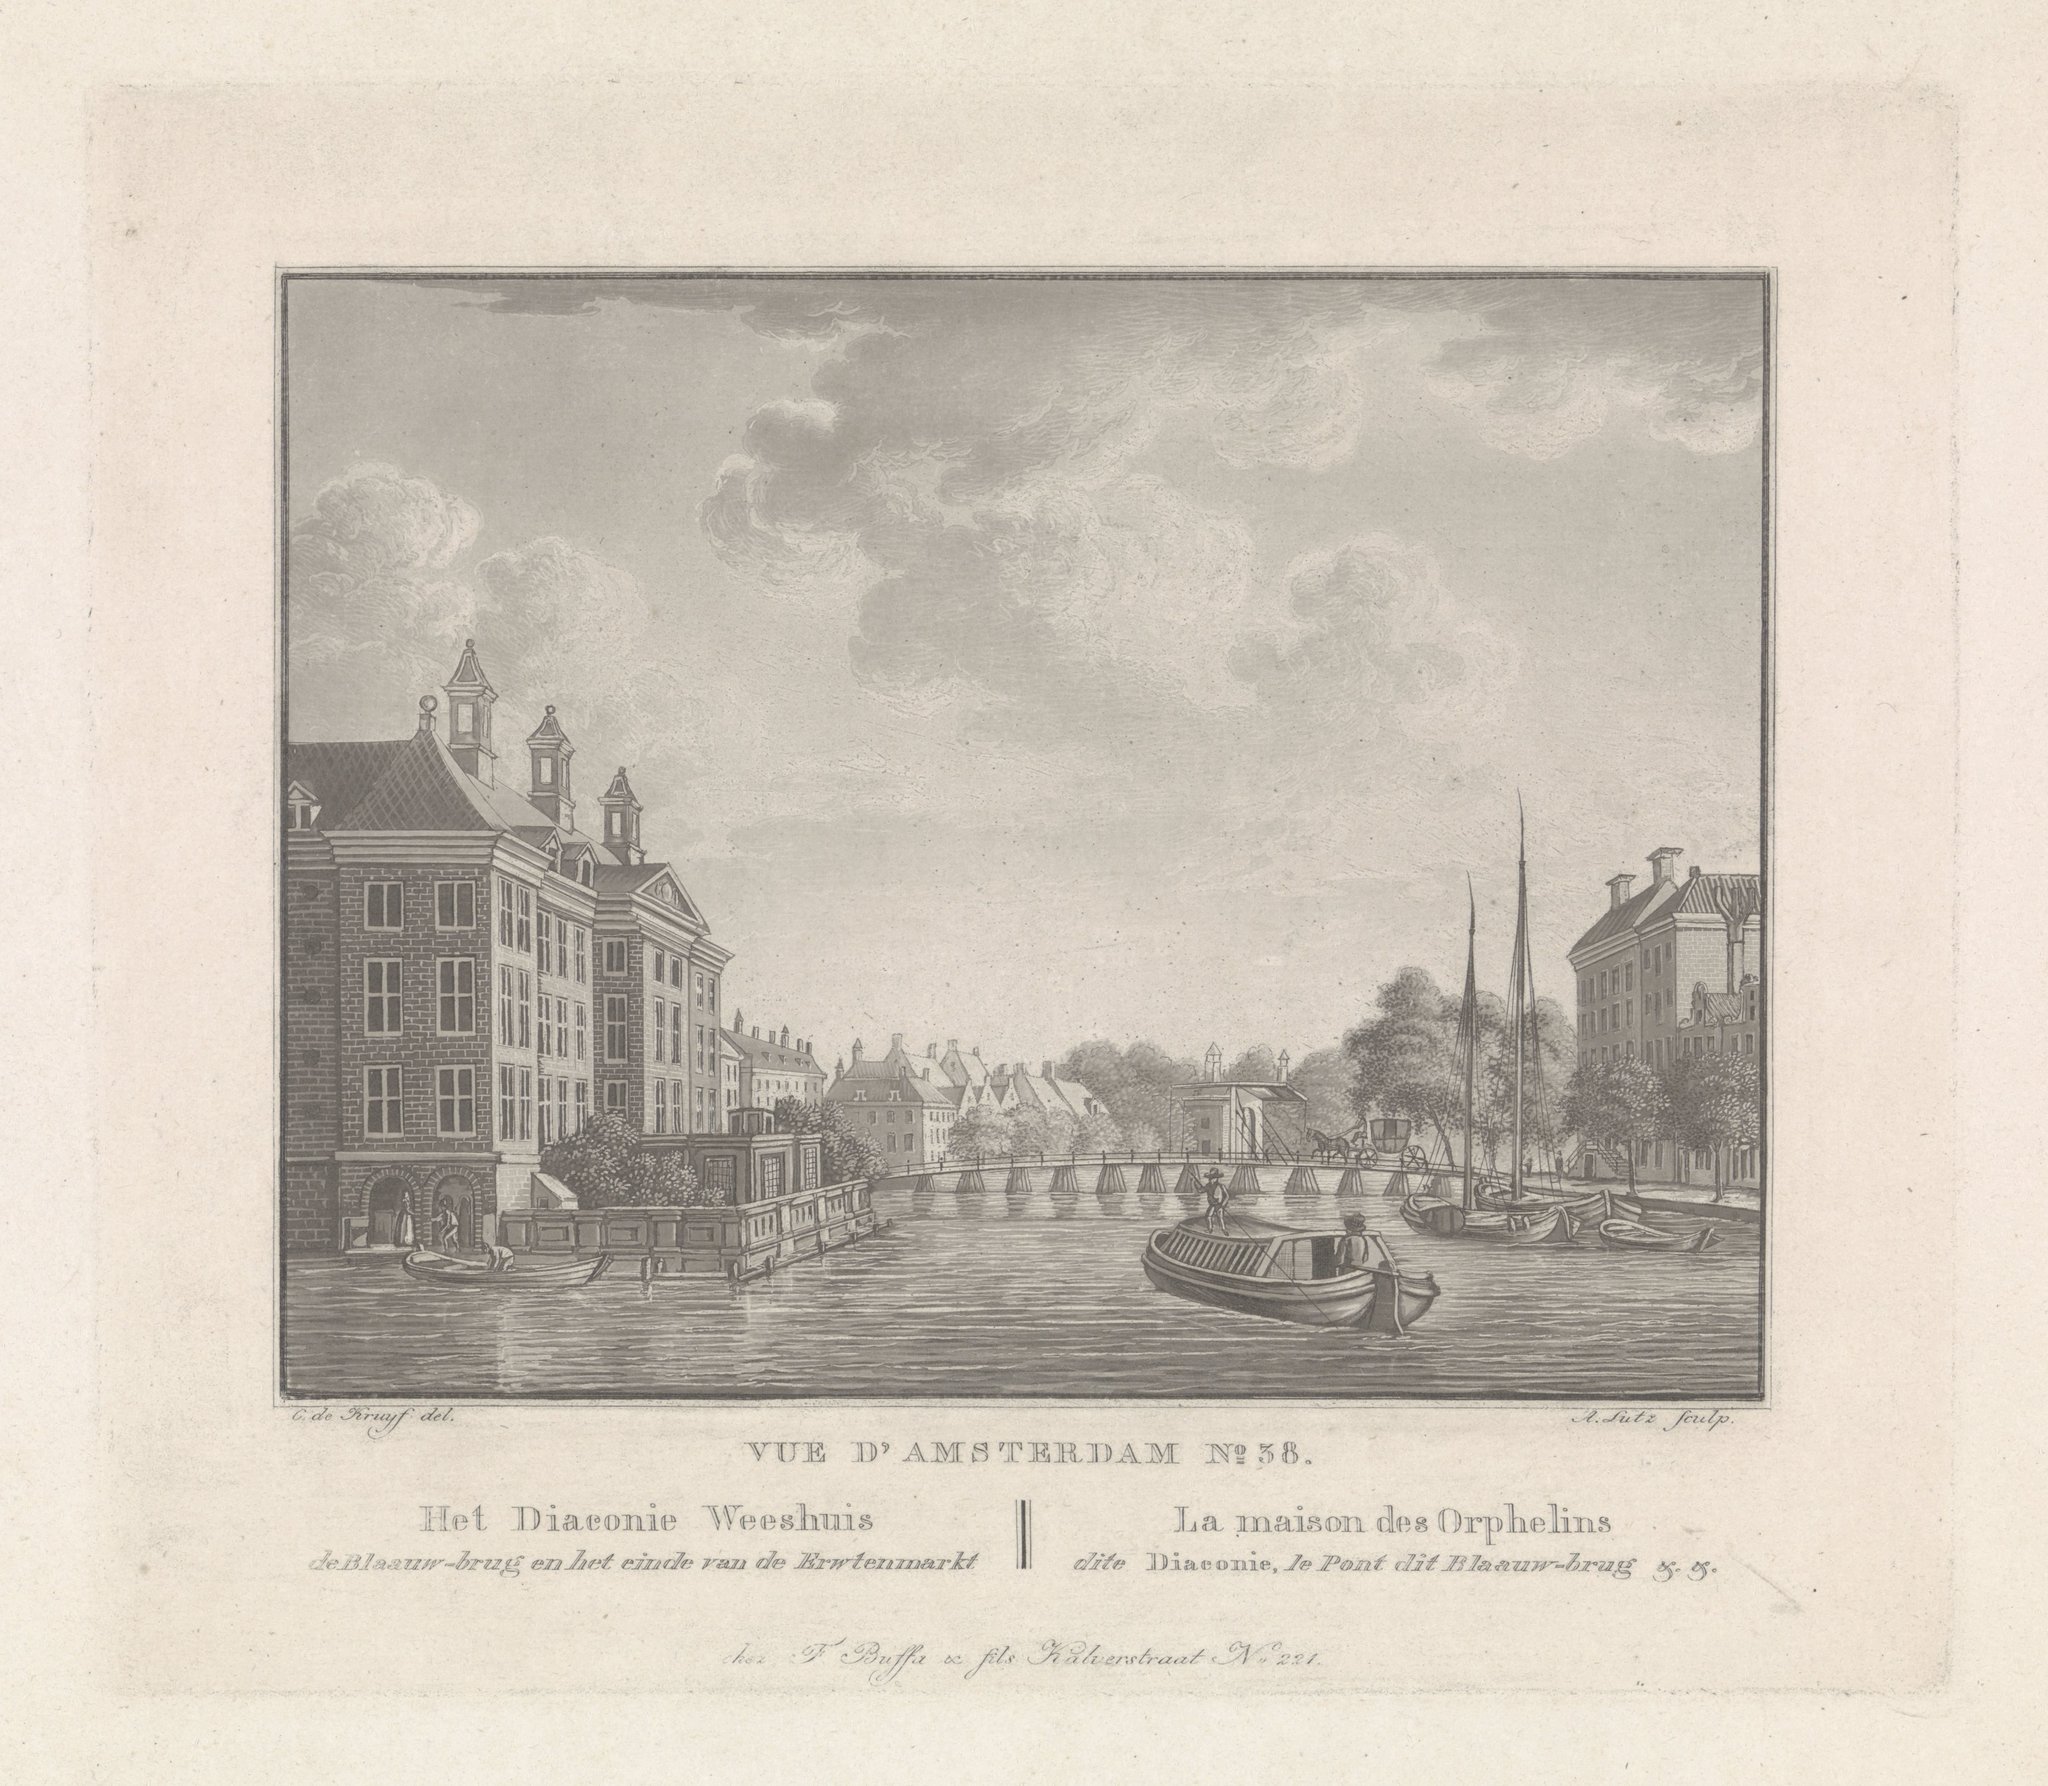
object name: print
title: Het Diaconie Weeshuis / La maison des Orphelins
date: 1825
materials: paper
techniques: aquatint, etching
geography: the hague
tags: foundling-hospital, canals, waters (in city)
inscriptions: collector's mark: Lugt 2228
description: Gezicht op het Diaconieweeshuis aan de Amstel te Amsterdam. Links de ingang van de Zwanenburgwal, op de achtergrond de Blauwbrug.